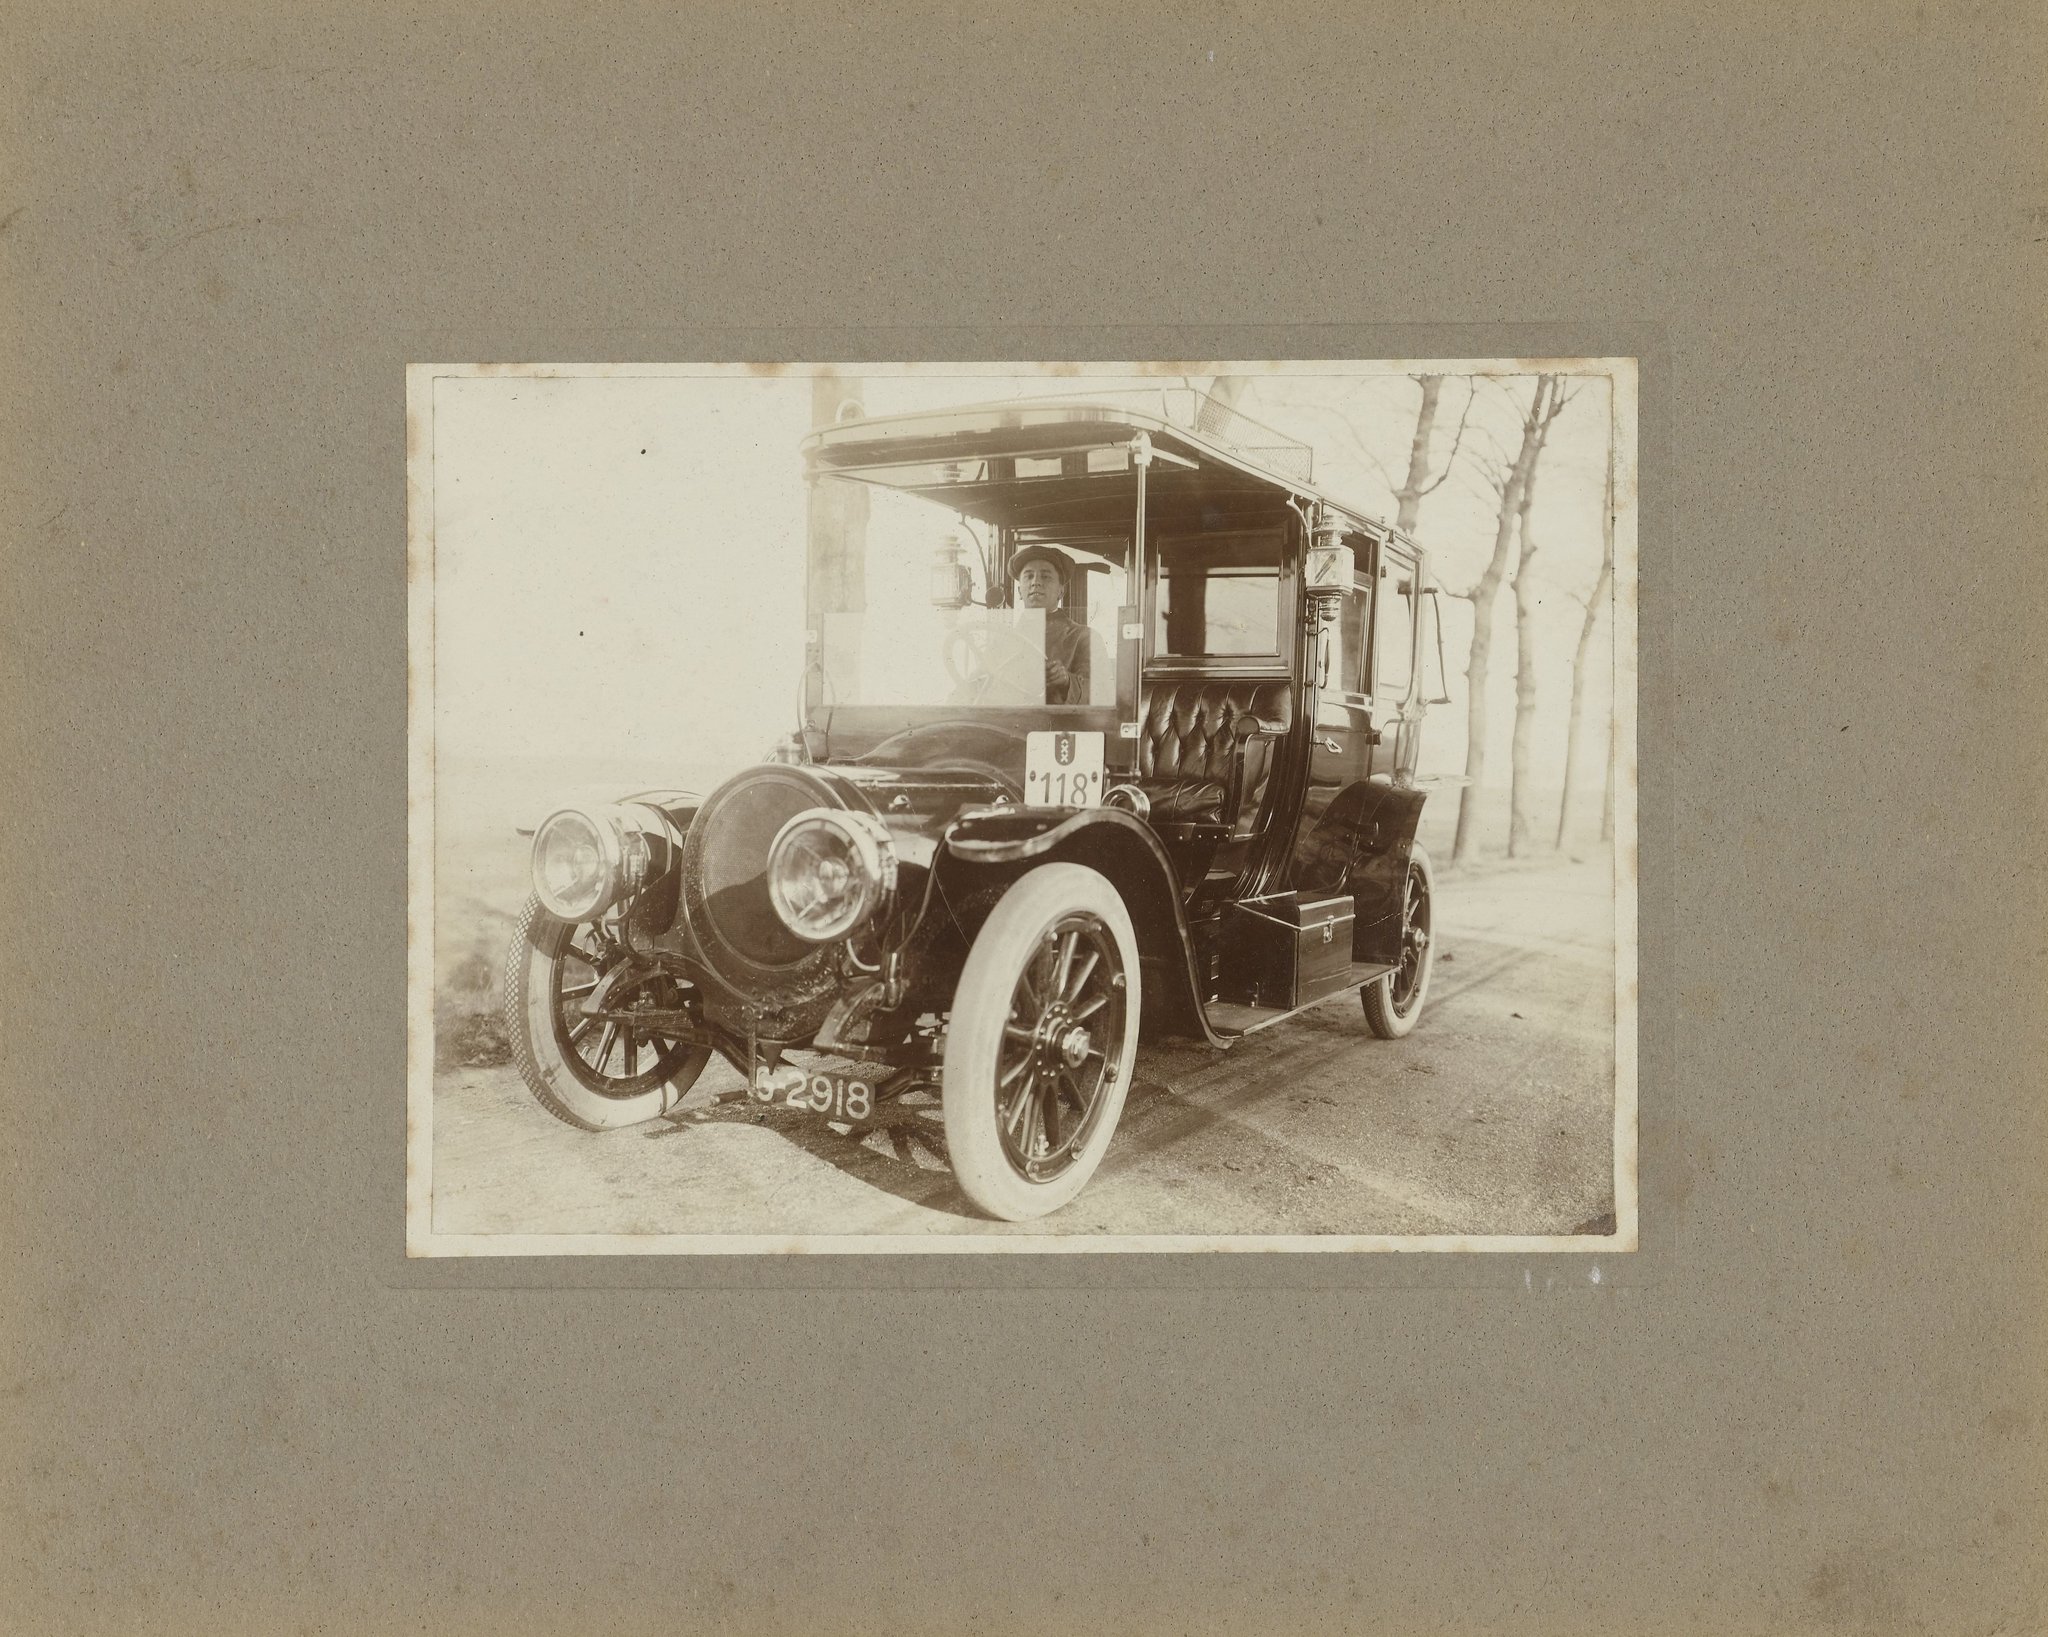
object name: photograph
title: Man in automobiel, nummer 118, voor huis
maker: Anonymous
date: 1900-1920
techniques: gelatin silver print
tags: automobile